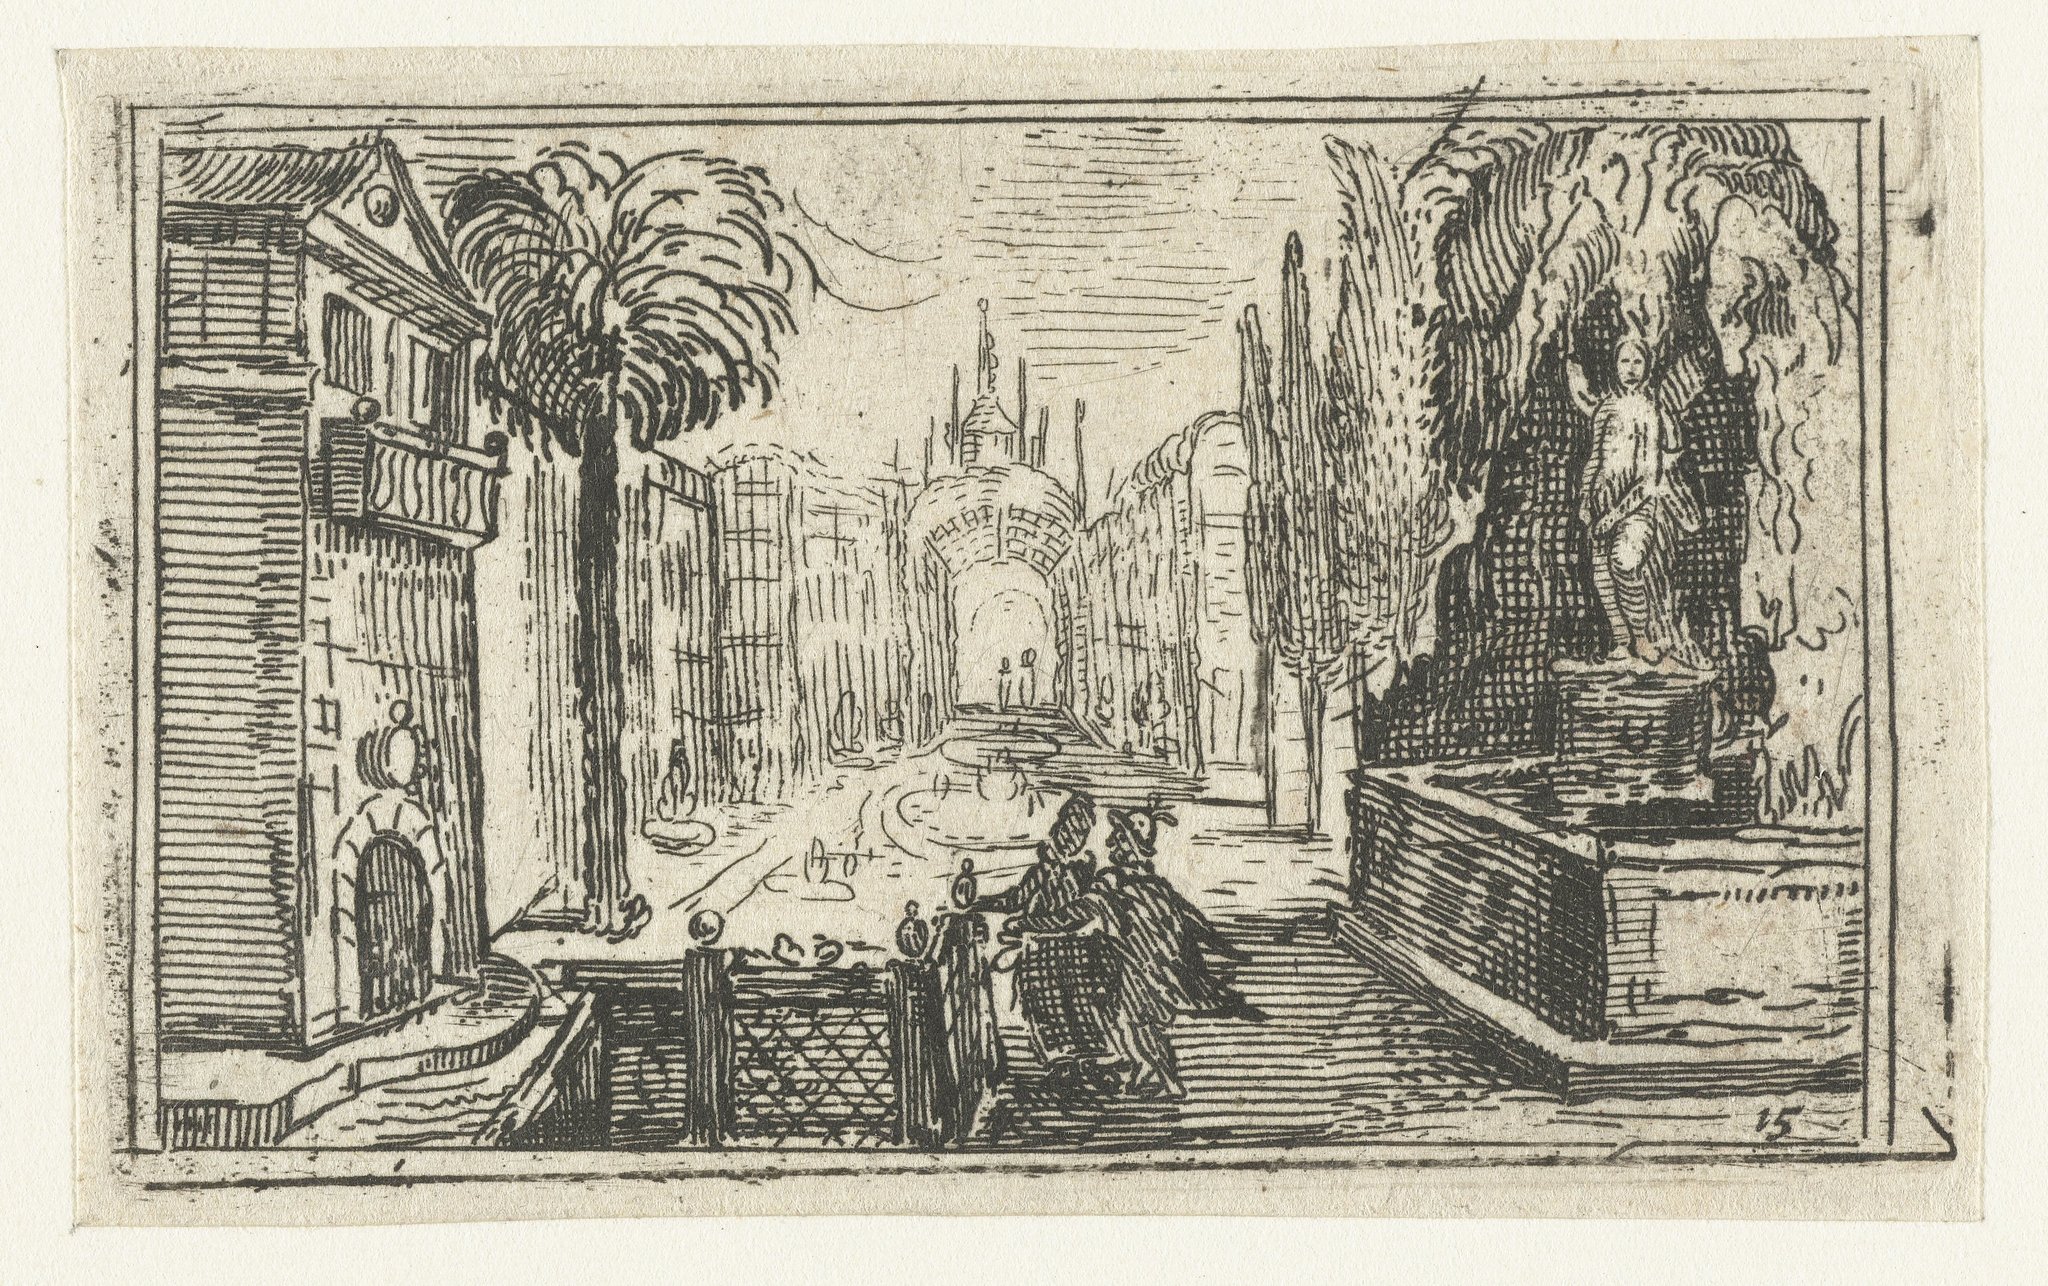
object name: print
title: Tuin met fantasiearchitectuur, fonteinen en grot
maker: Anonymous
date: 1600-1699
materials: paper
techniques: engraving, etching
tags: artificial grotto in garden, garden ornaments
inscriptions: collector's mark: Lugt 240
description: Keyes 1984 noemt twee mogelijke vervaardigers van deze prent, Cornelis Claesz. van Wieringen en Cornelis Bol, zie p. 331